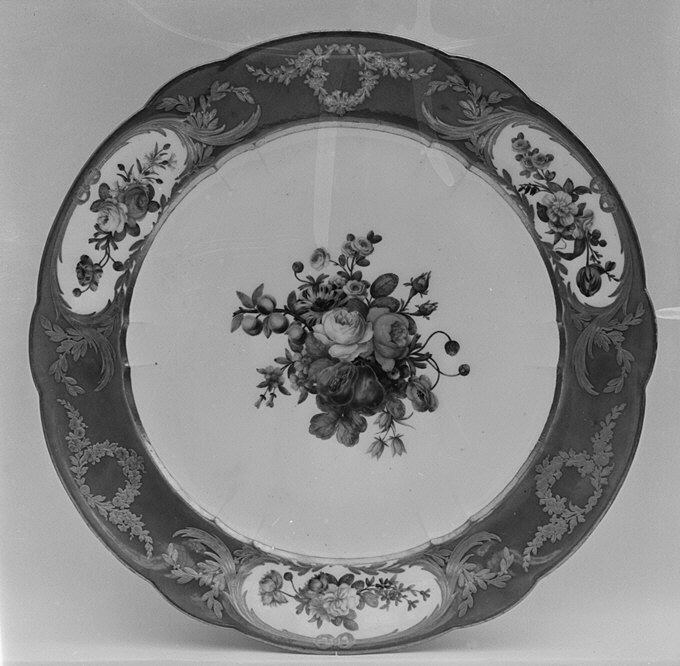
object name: plate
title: Plate (part of a service)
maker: sèvres manufactory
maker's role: manufactory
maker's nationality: french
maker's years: 1740-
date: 1775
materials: soft paste porcelain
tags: fruit,flowers